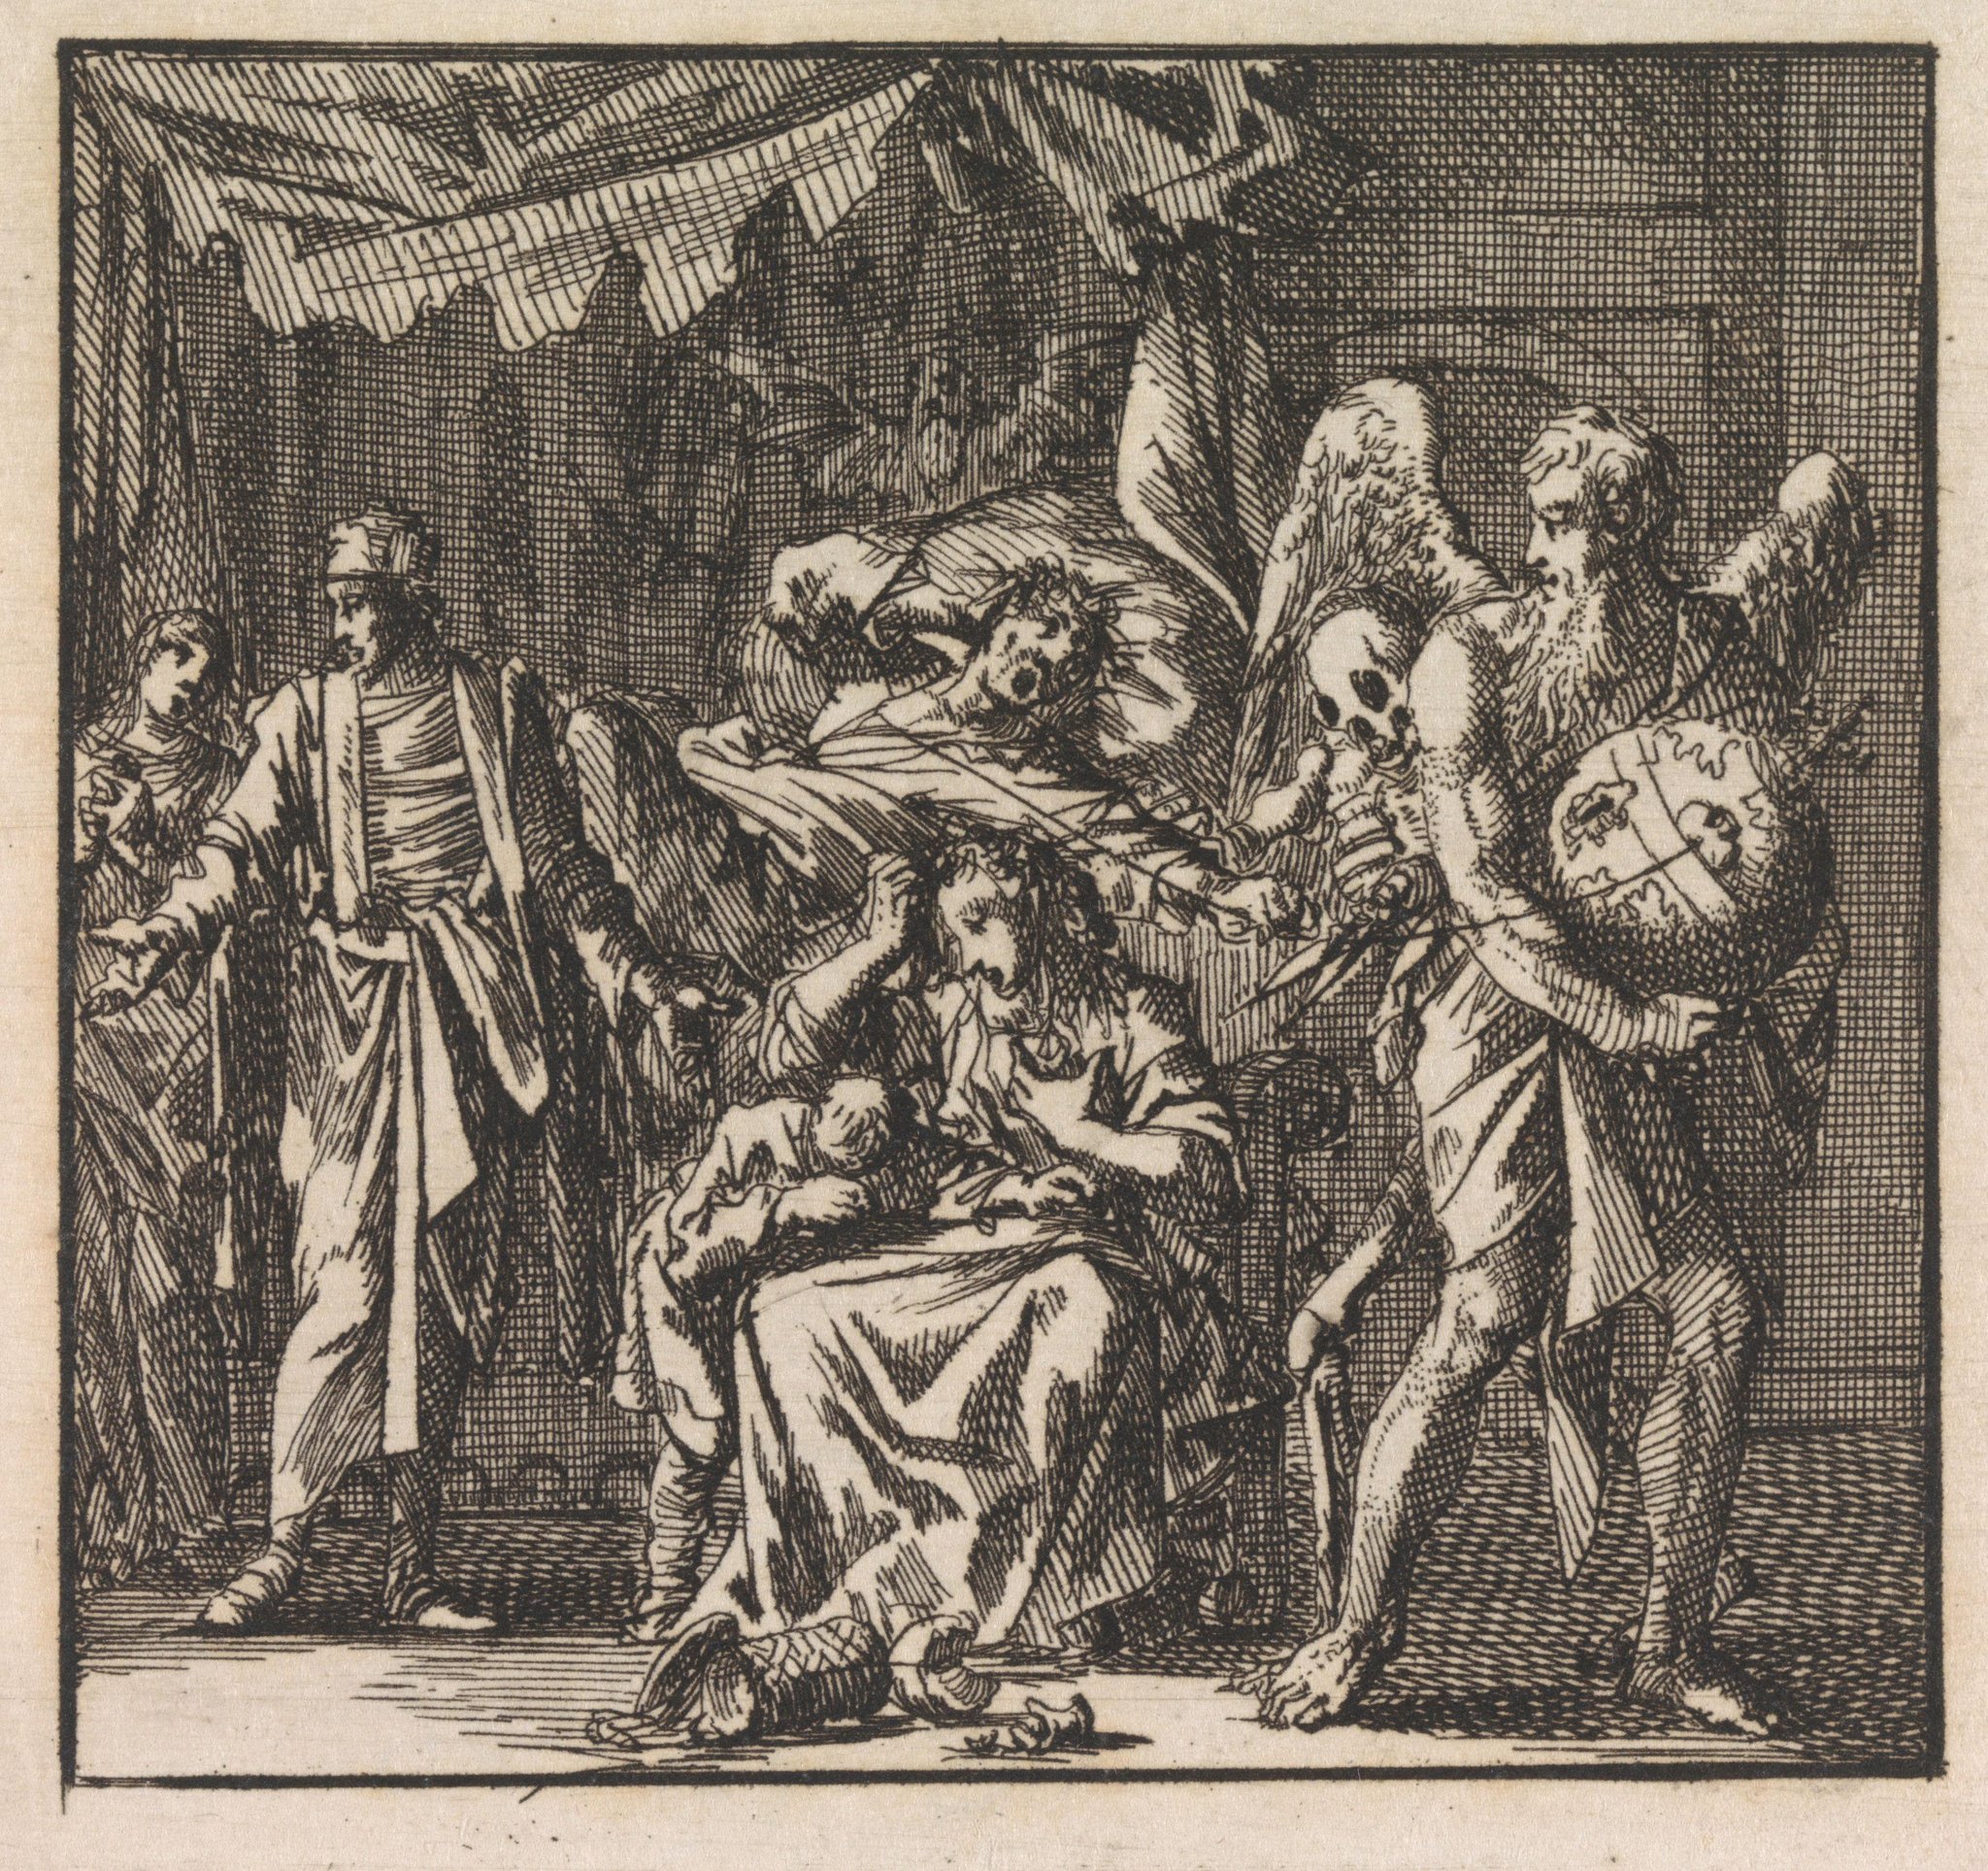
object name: print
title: Dood staat op het punt om de levensdraad van een stervende man door te knippen die hem probeert tegen te houden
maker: jan luyken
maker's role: draughtsman, print maker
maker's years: 1649-1712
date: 1710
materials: paper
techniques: etching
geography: amsterdam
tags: dying, father time, man with wings and scythe, death as skeleton - ff - death as female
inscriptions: collector's mark: Lugt 2228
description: Illustratie uit: Luyken, Jan. De onwaardige wereld, vertoond in vyftig zinnebeelden, met godlyke spreuken en stichtelyke verzen. Amsterdam: Pieter Arentsz. II (wed.) en Cornelis van der Sys, 1710, p. 200.